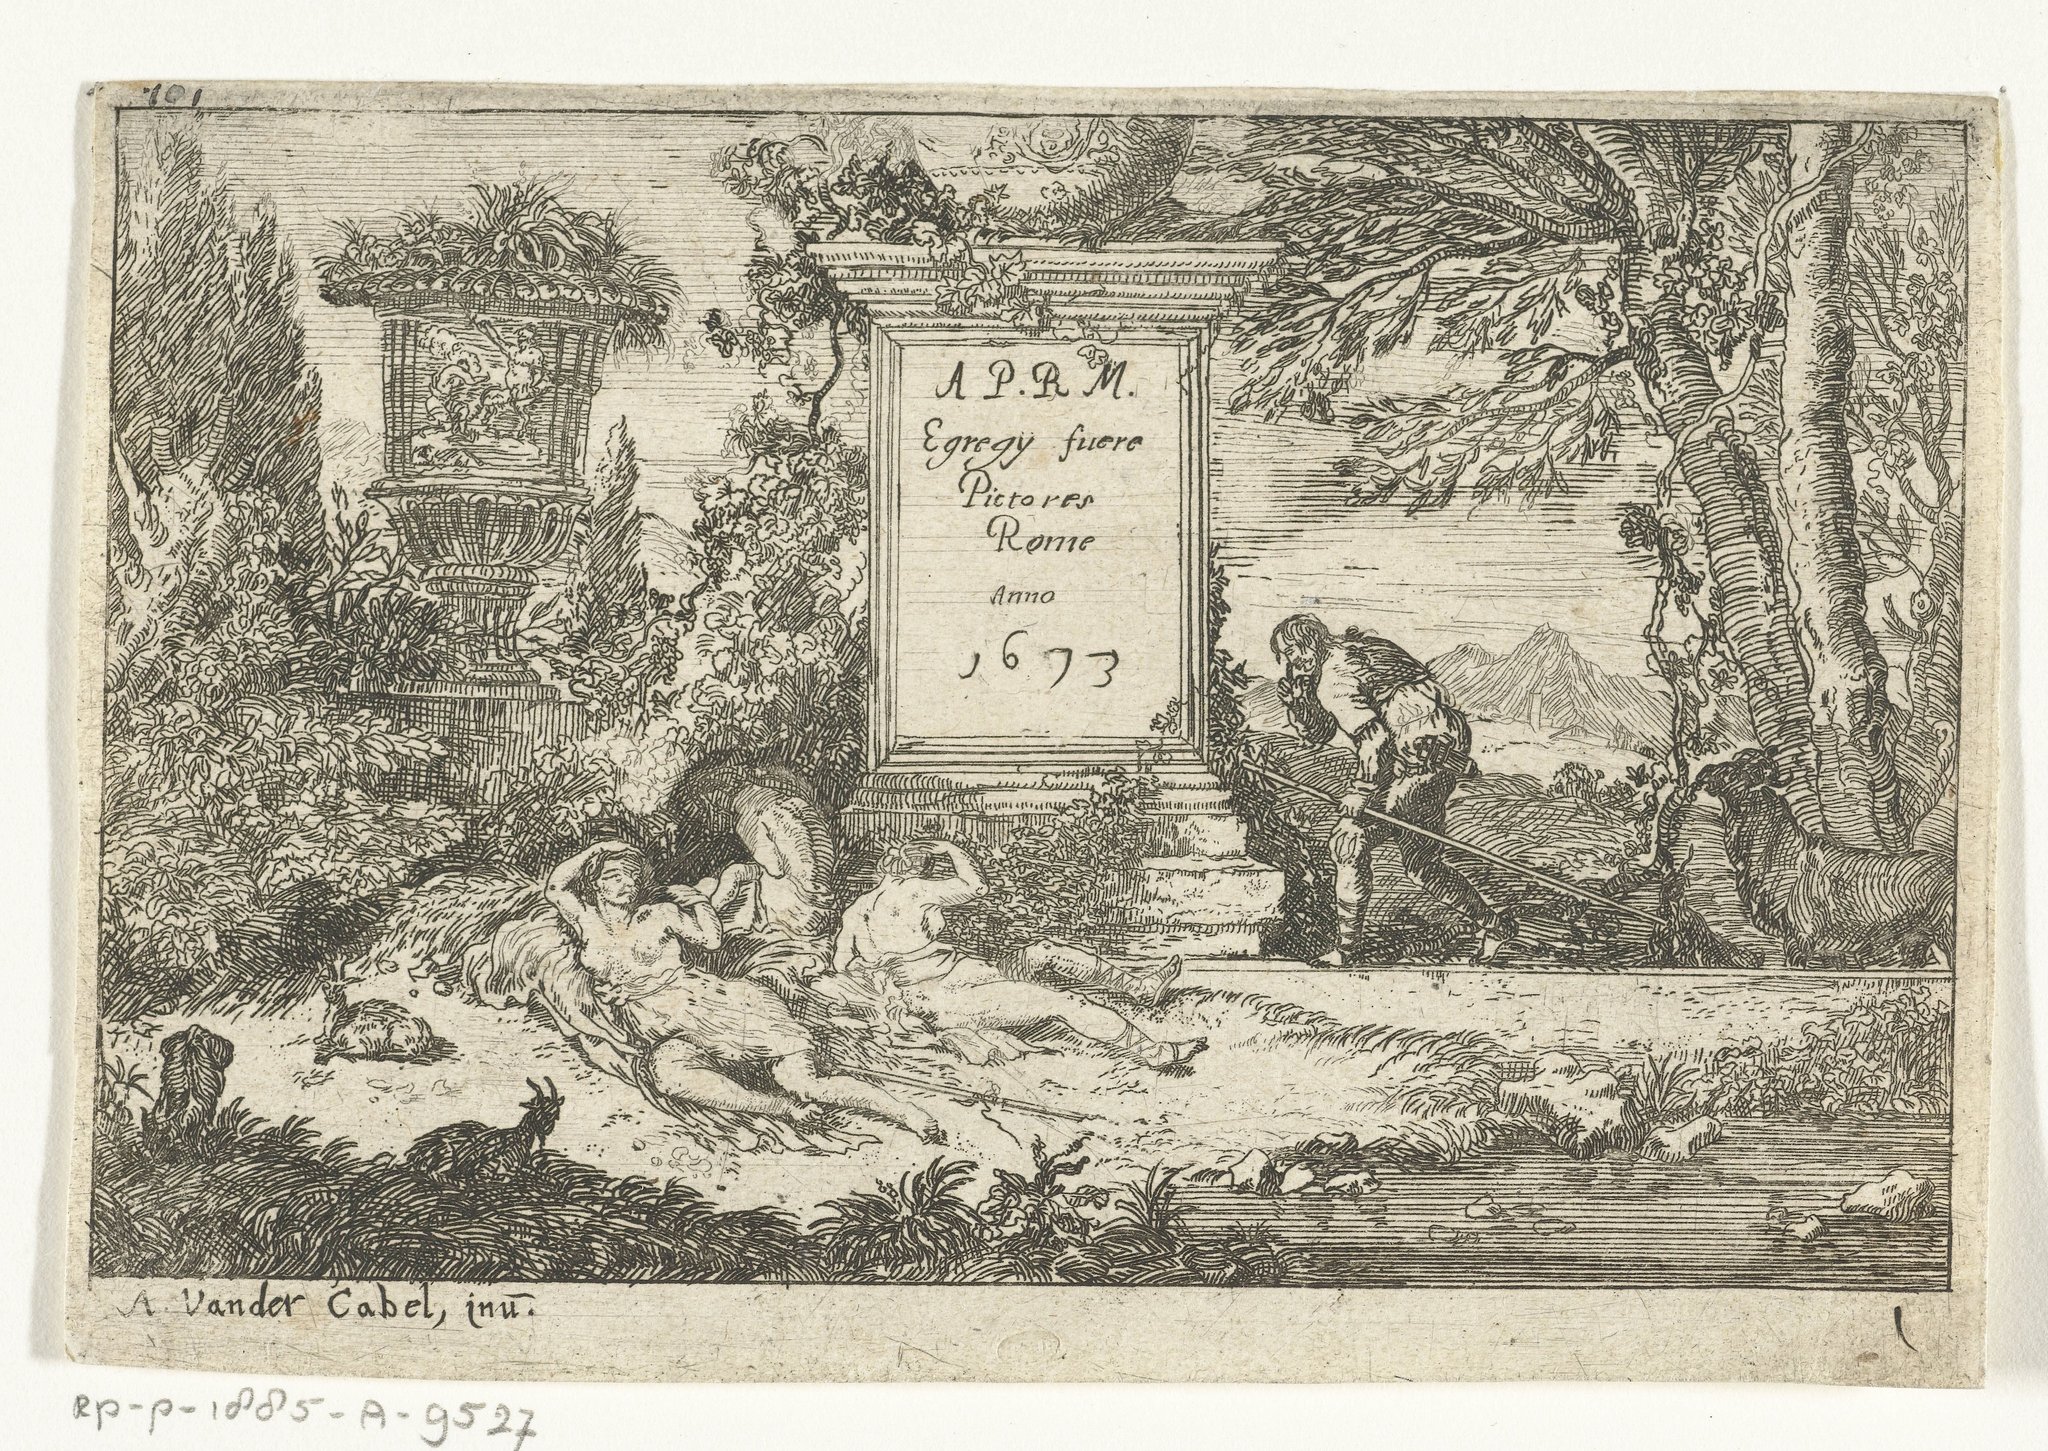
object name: print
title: Slapende herderinnen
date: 1673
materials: paper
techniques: etching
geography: rome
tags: herding, herdsman, herdswoman, shepherd, shepherdess, cowherd, etc., sleeping; unconsciousness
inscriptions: collector's mark: Lugt 2228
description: Drie schaars geklede vrouwen aan de voet van een zuil waarnaast een staande man, een koe en enkele geiten.